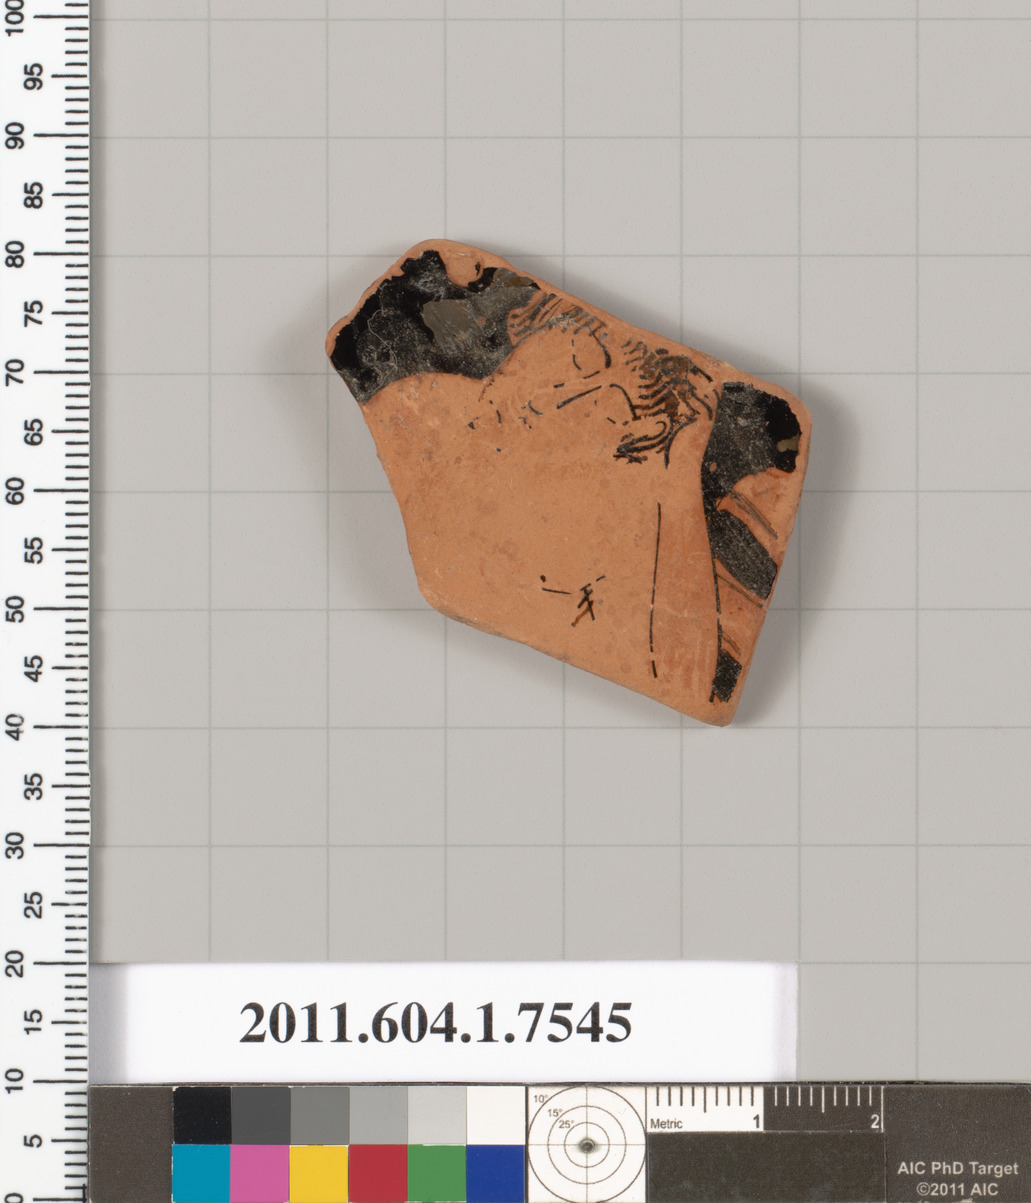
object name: kylix fragment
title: Terracotta fragment of a kylix (drinking cup)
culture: greek, attic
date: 470-460 BCE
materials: terracotta